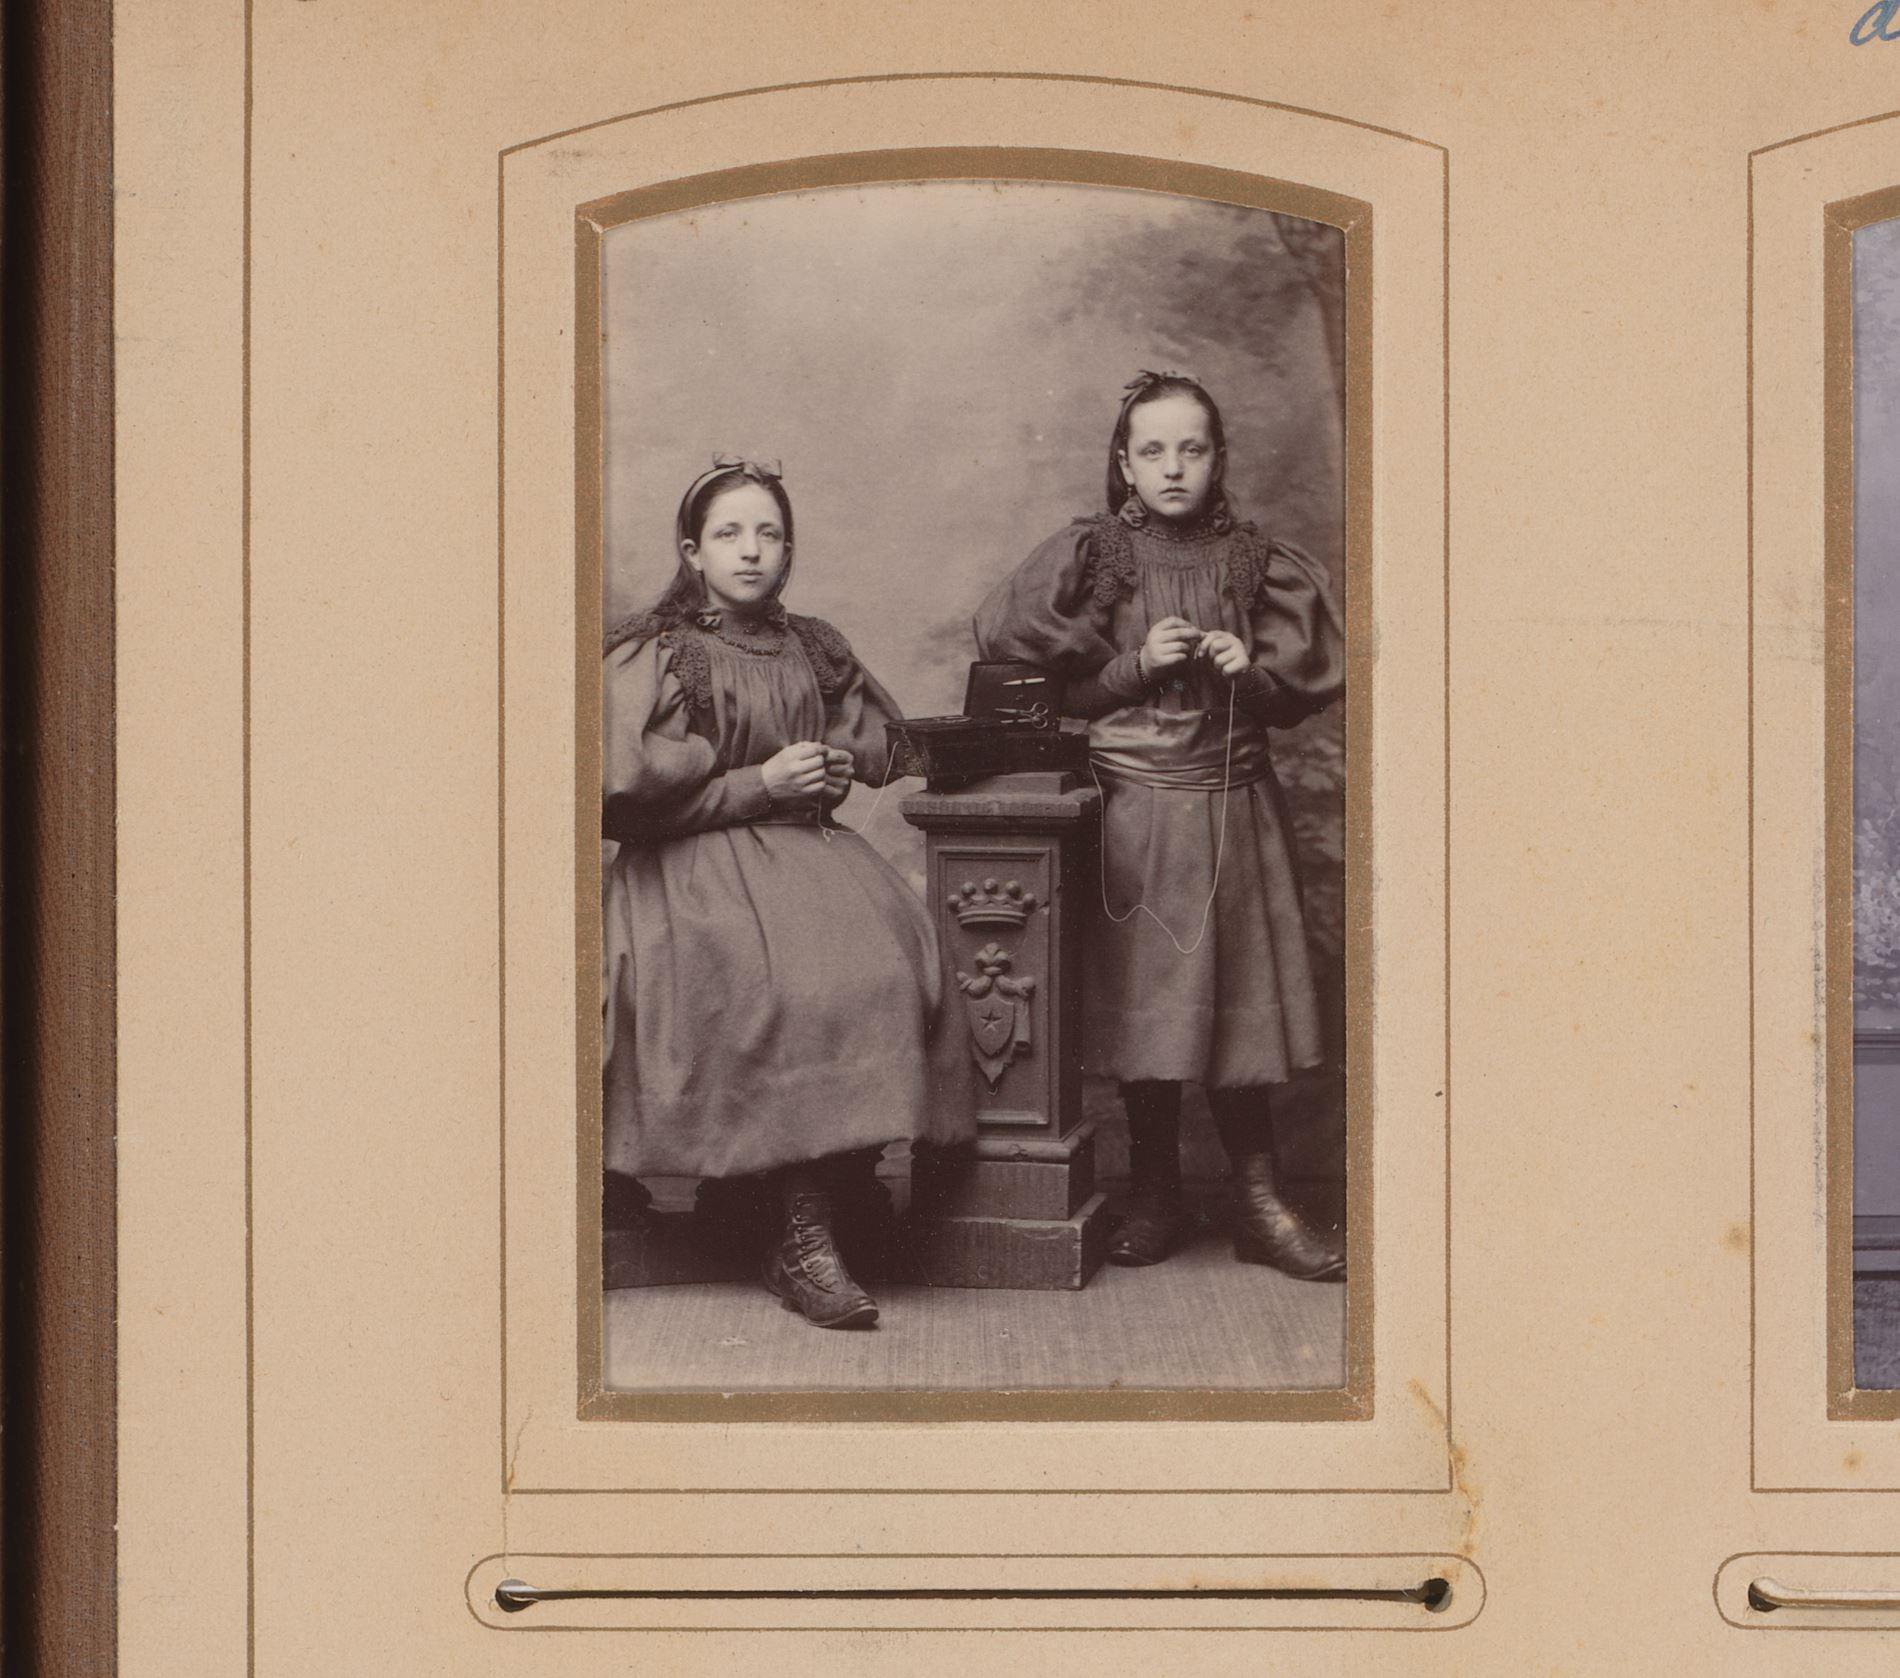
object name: album leaf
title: Portret van twee meisjes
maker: Anonymous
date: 1860-1900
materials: cardboard, photographic support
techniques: albumen print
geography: netherlands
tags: historical persons - bb - woman, girl (child between toddler and youth) (+ two persons)